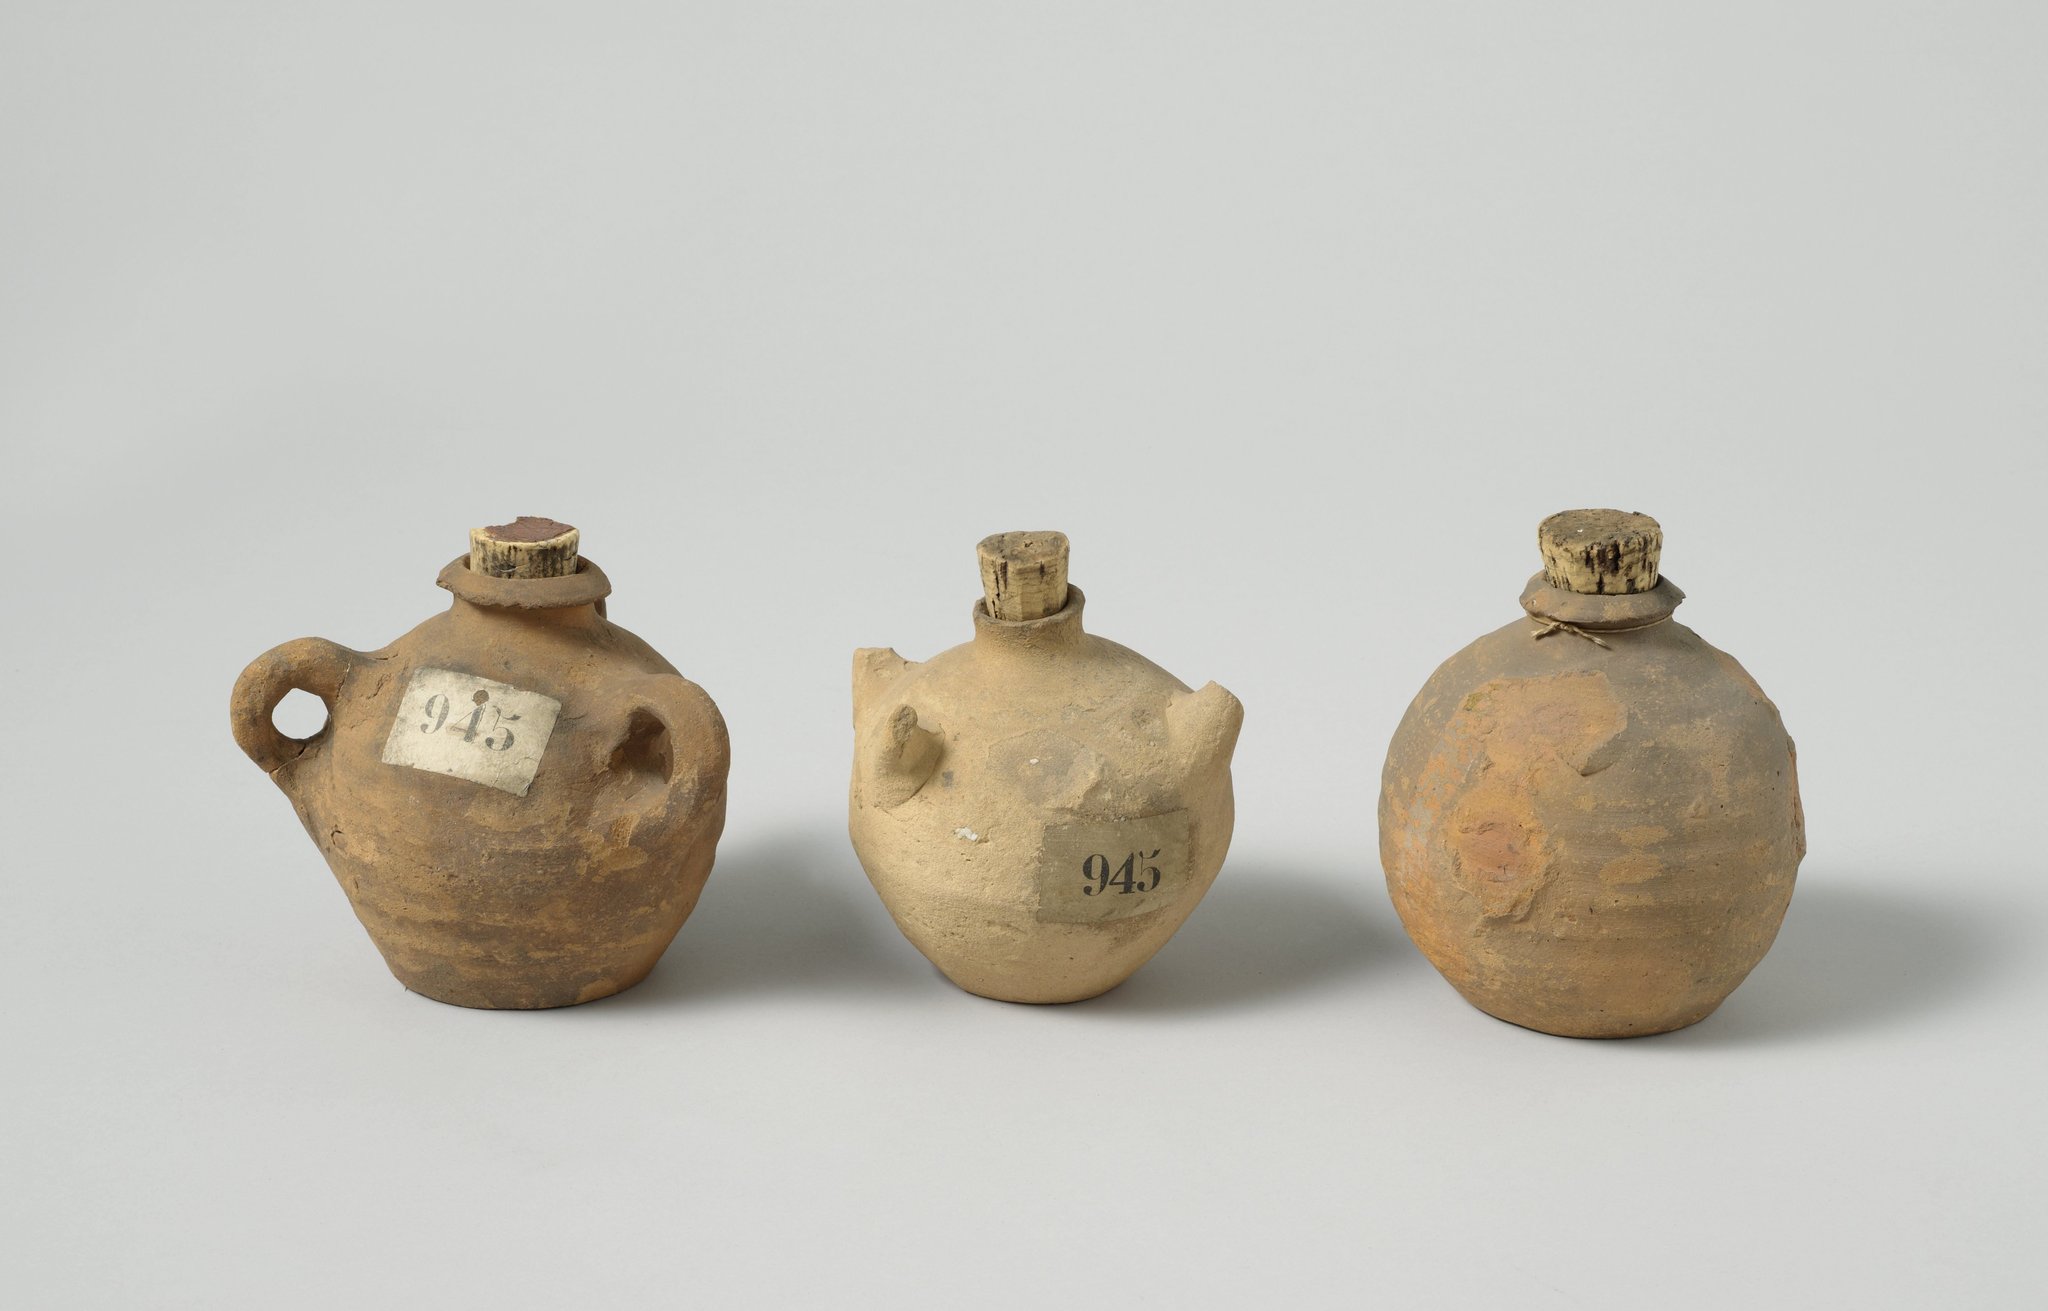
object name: fire pot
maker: Anonymous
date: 1550-1700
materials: cork, earthenware, fuel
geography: netherlands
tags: flushing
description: Ronde aardewerken pot met een korte nek. De drie verticaal geplaatste oren van deze pot zijn glad afgebroken en verloren; deze pot heeft nog resten van de oorspronkelijke inhoud.